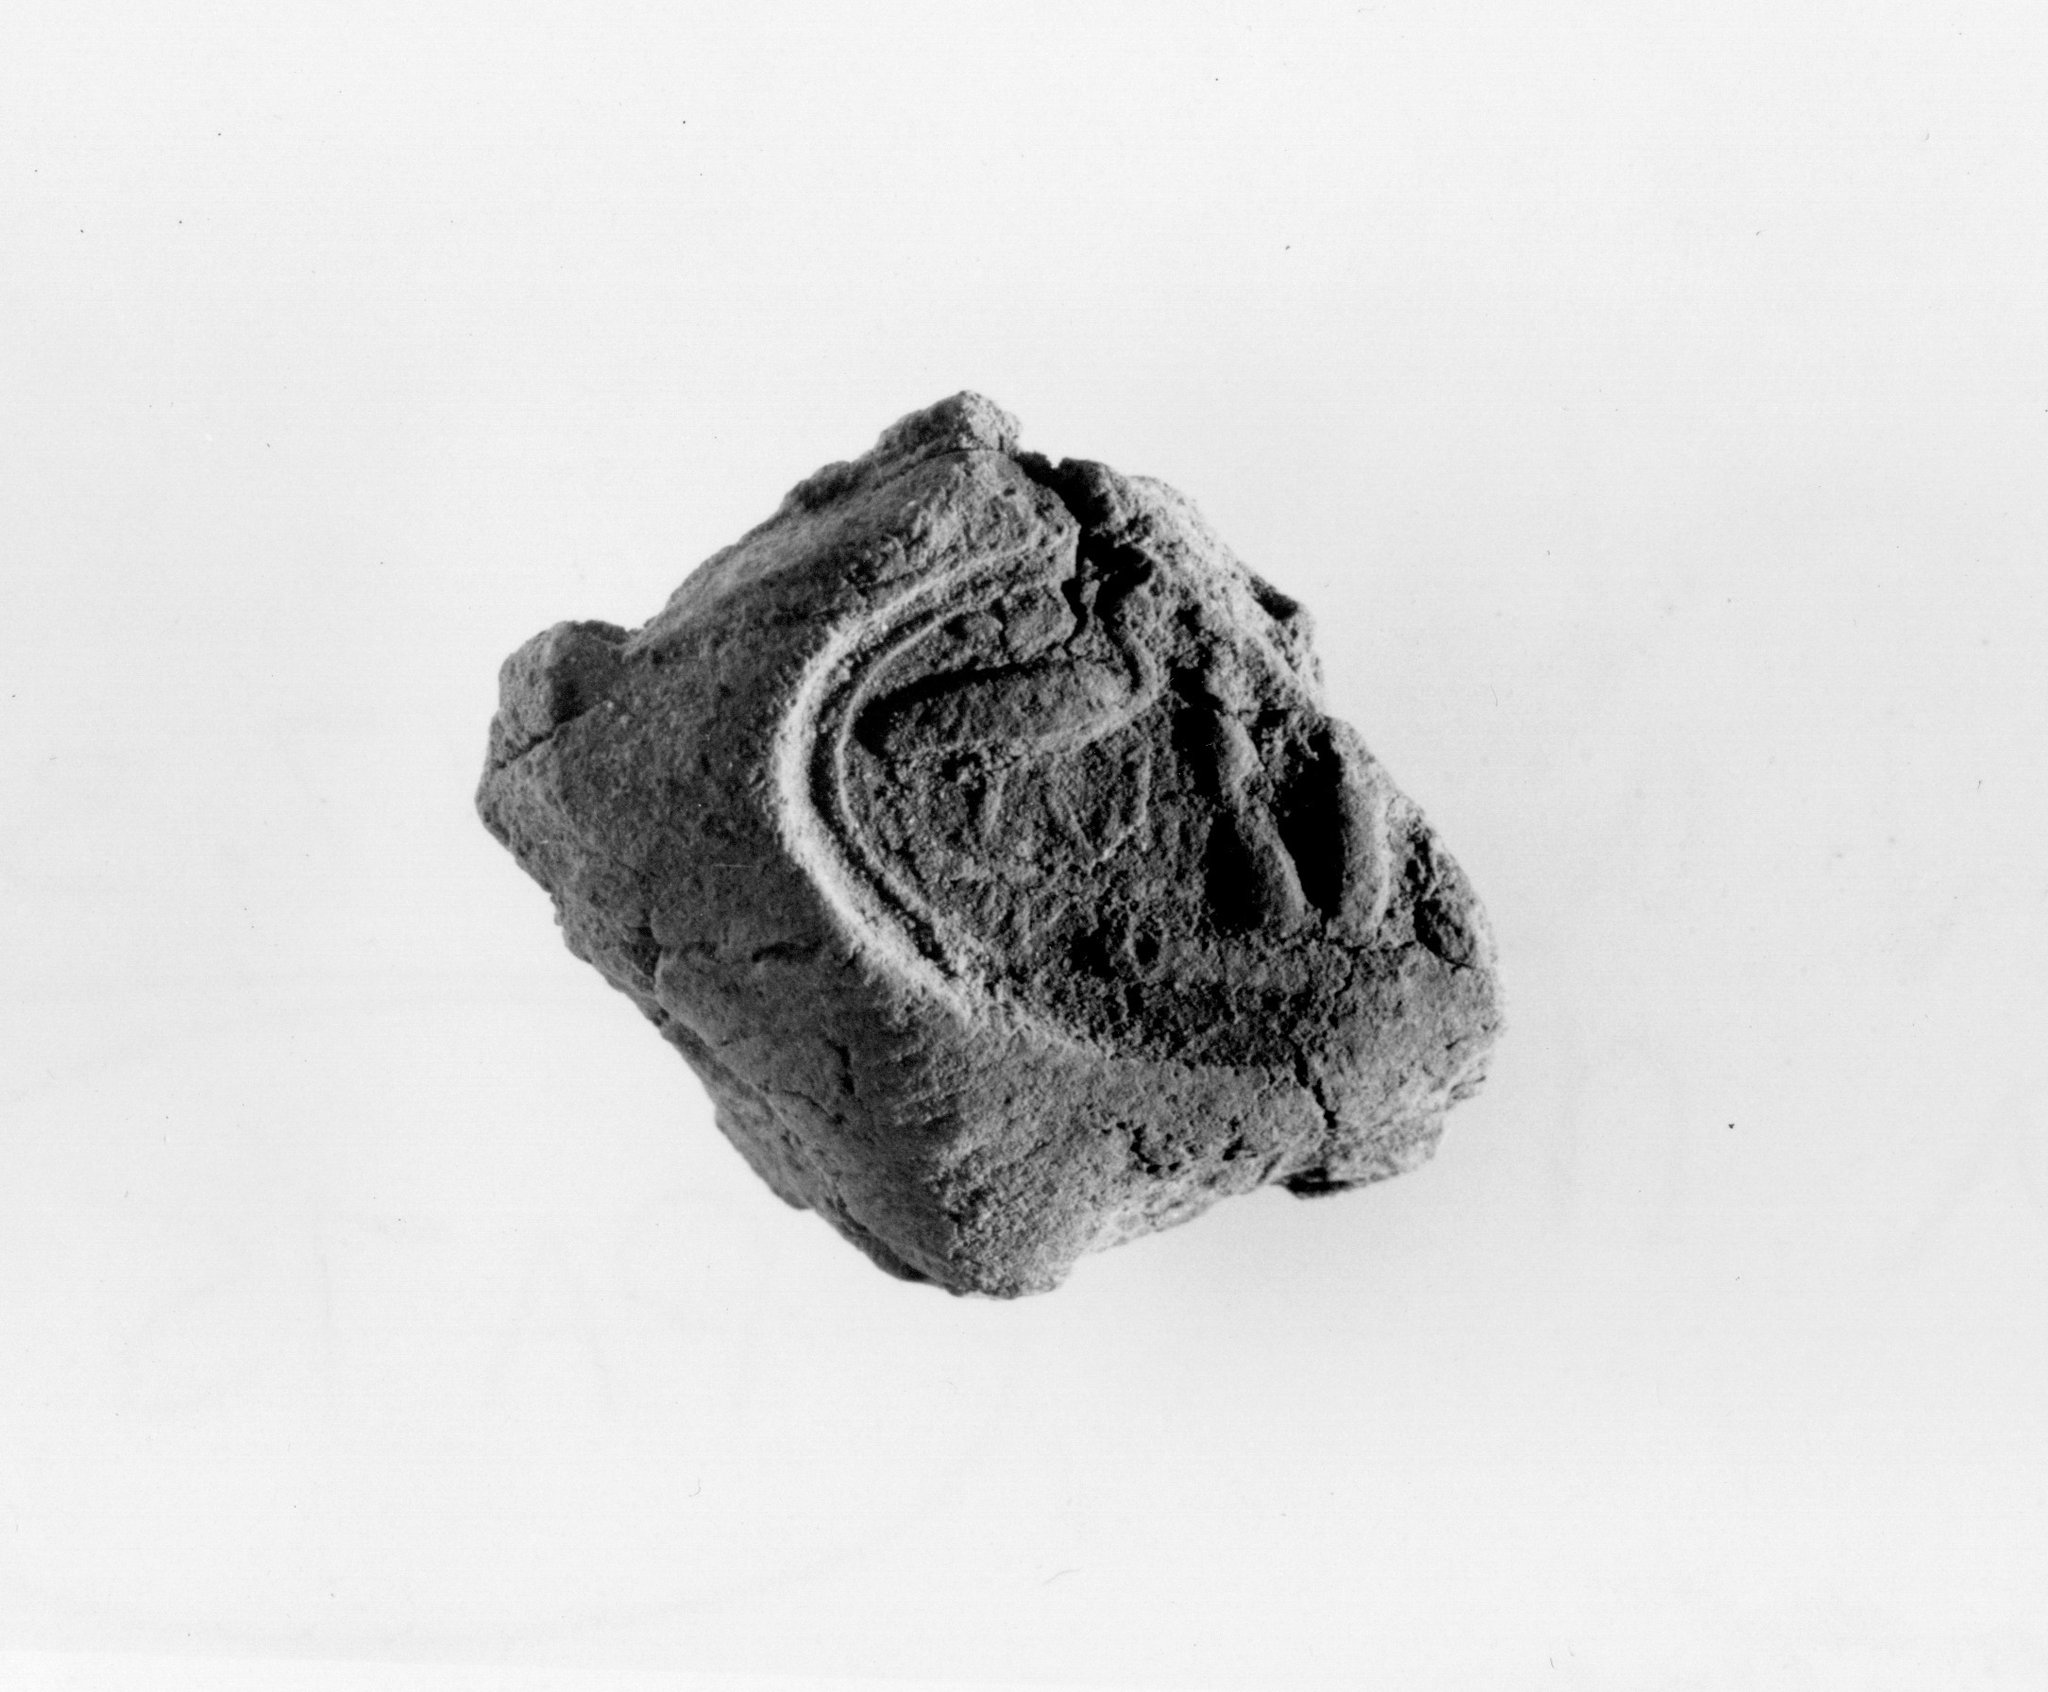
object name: sealing, nebmaatre, amenhotep iii, heb sed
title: Document Sealing With the Throne Name of Amenhotep III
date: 1390-1352 BCE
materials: mud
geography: egypt